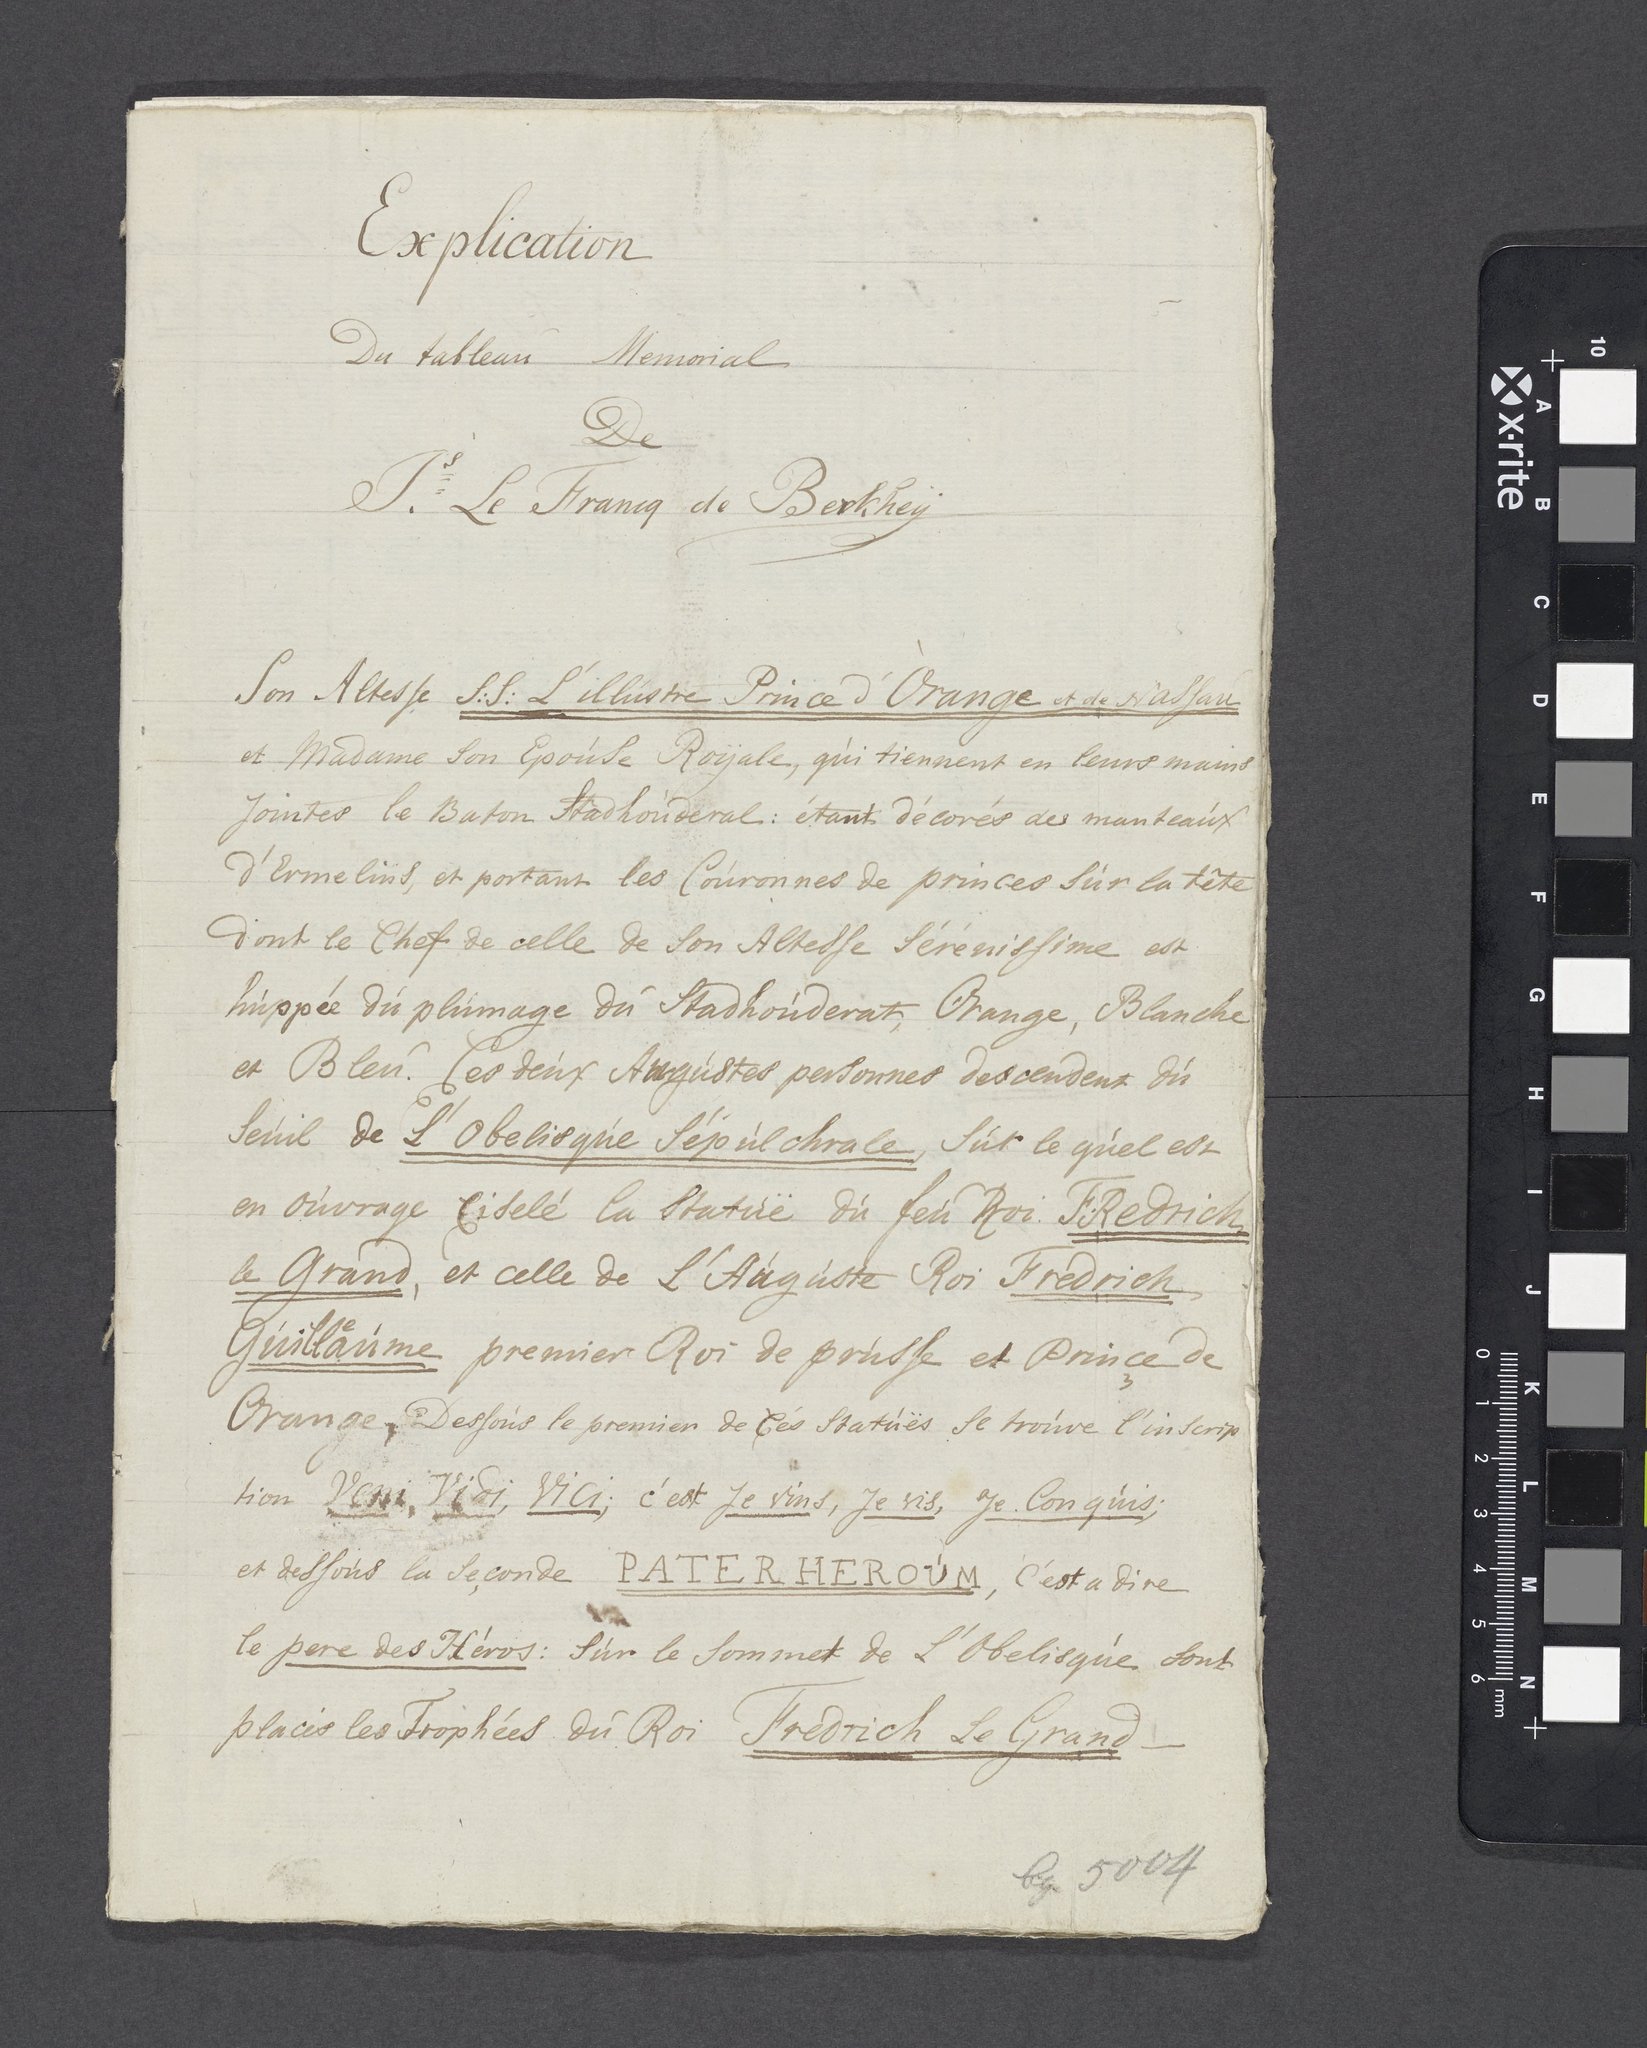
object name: manuscript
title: Handschrift met verklaring van de allegorie ter ere van de koning van Pruisen voor zijn herstel van het stadhouderschap van Willem V, 1788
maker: johannes le francq van berkhey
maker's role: draughtsman, print maker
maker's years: 1729-1812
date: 1789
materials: paper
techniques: letterpress printing, writing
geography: leiden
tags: leiden, print maker, johannes le francq van berkhey, william v (prince of orange)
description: Handschrift op vier dubbelgevouwen bladen papier met een uitleg in het Frans van de voorstelling van de allegorie ter ere van de koning van Pruisen voor zijn herstel van het stadhouderschap van Willem V, 1788. Tekst in het Frans op alle zestien bladzijden. Bij het handschrift de gedrukte verklaring in het Frans op twee losse bladen. Hierbij ook een los gedrukt bericht op welke wijze het lege cartouche dat bij de Nederlandse uitleg zit gebruikt moet worden.